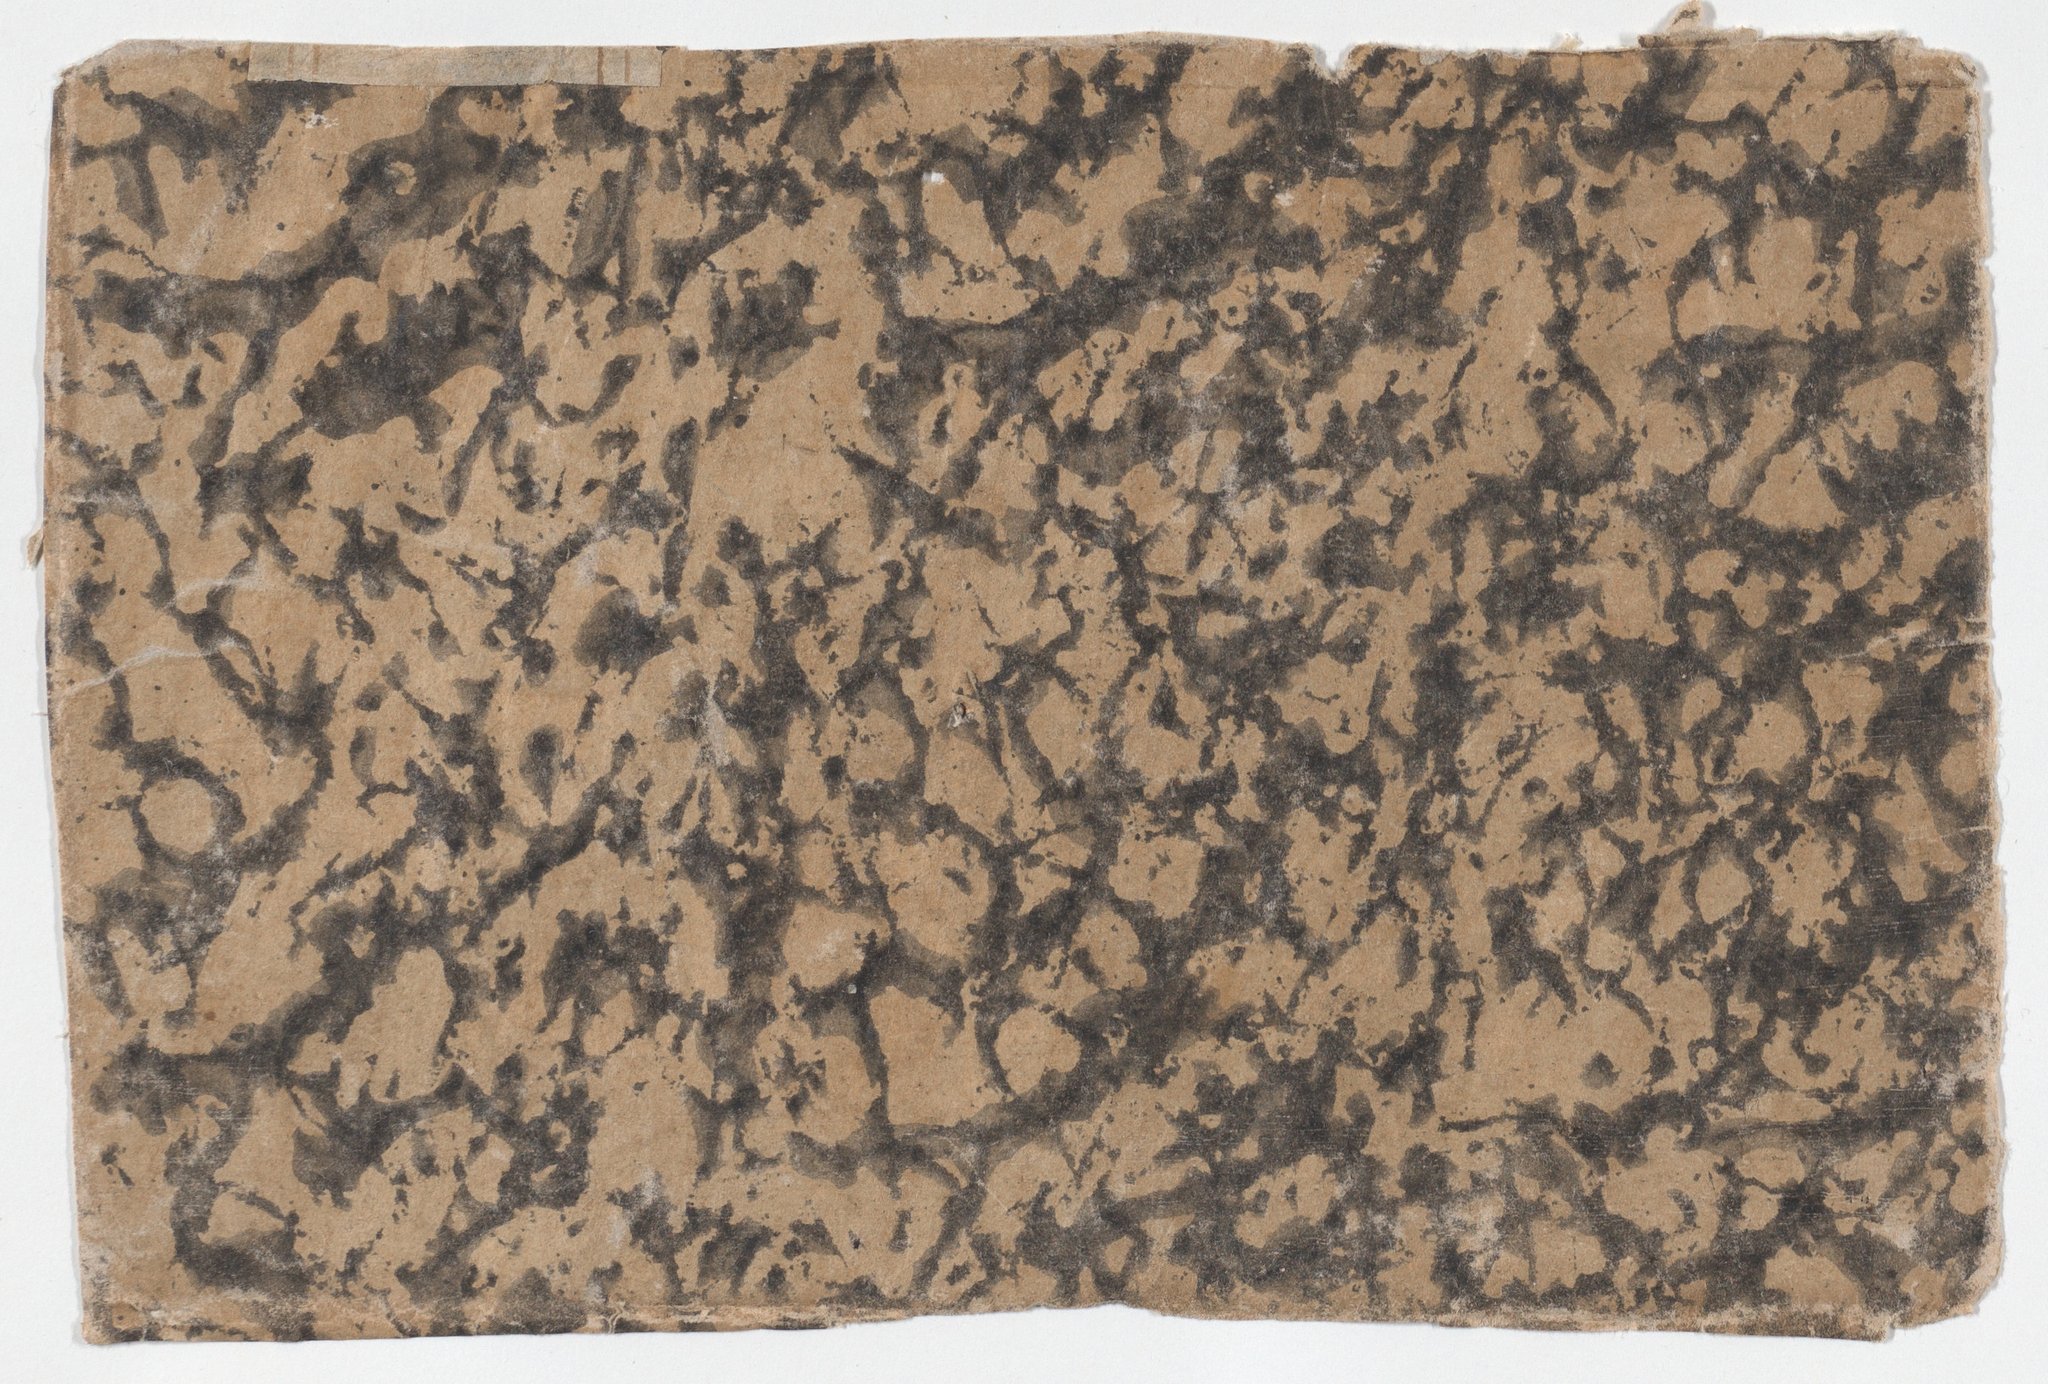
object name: print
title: Sheet with overall splotchy pattern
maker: Anonymous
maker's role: artist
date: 1801-1900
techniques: relief print